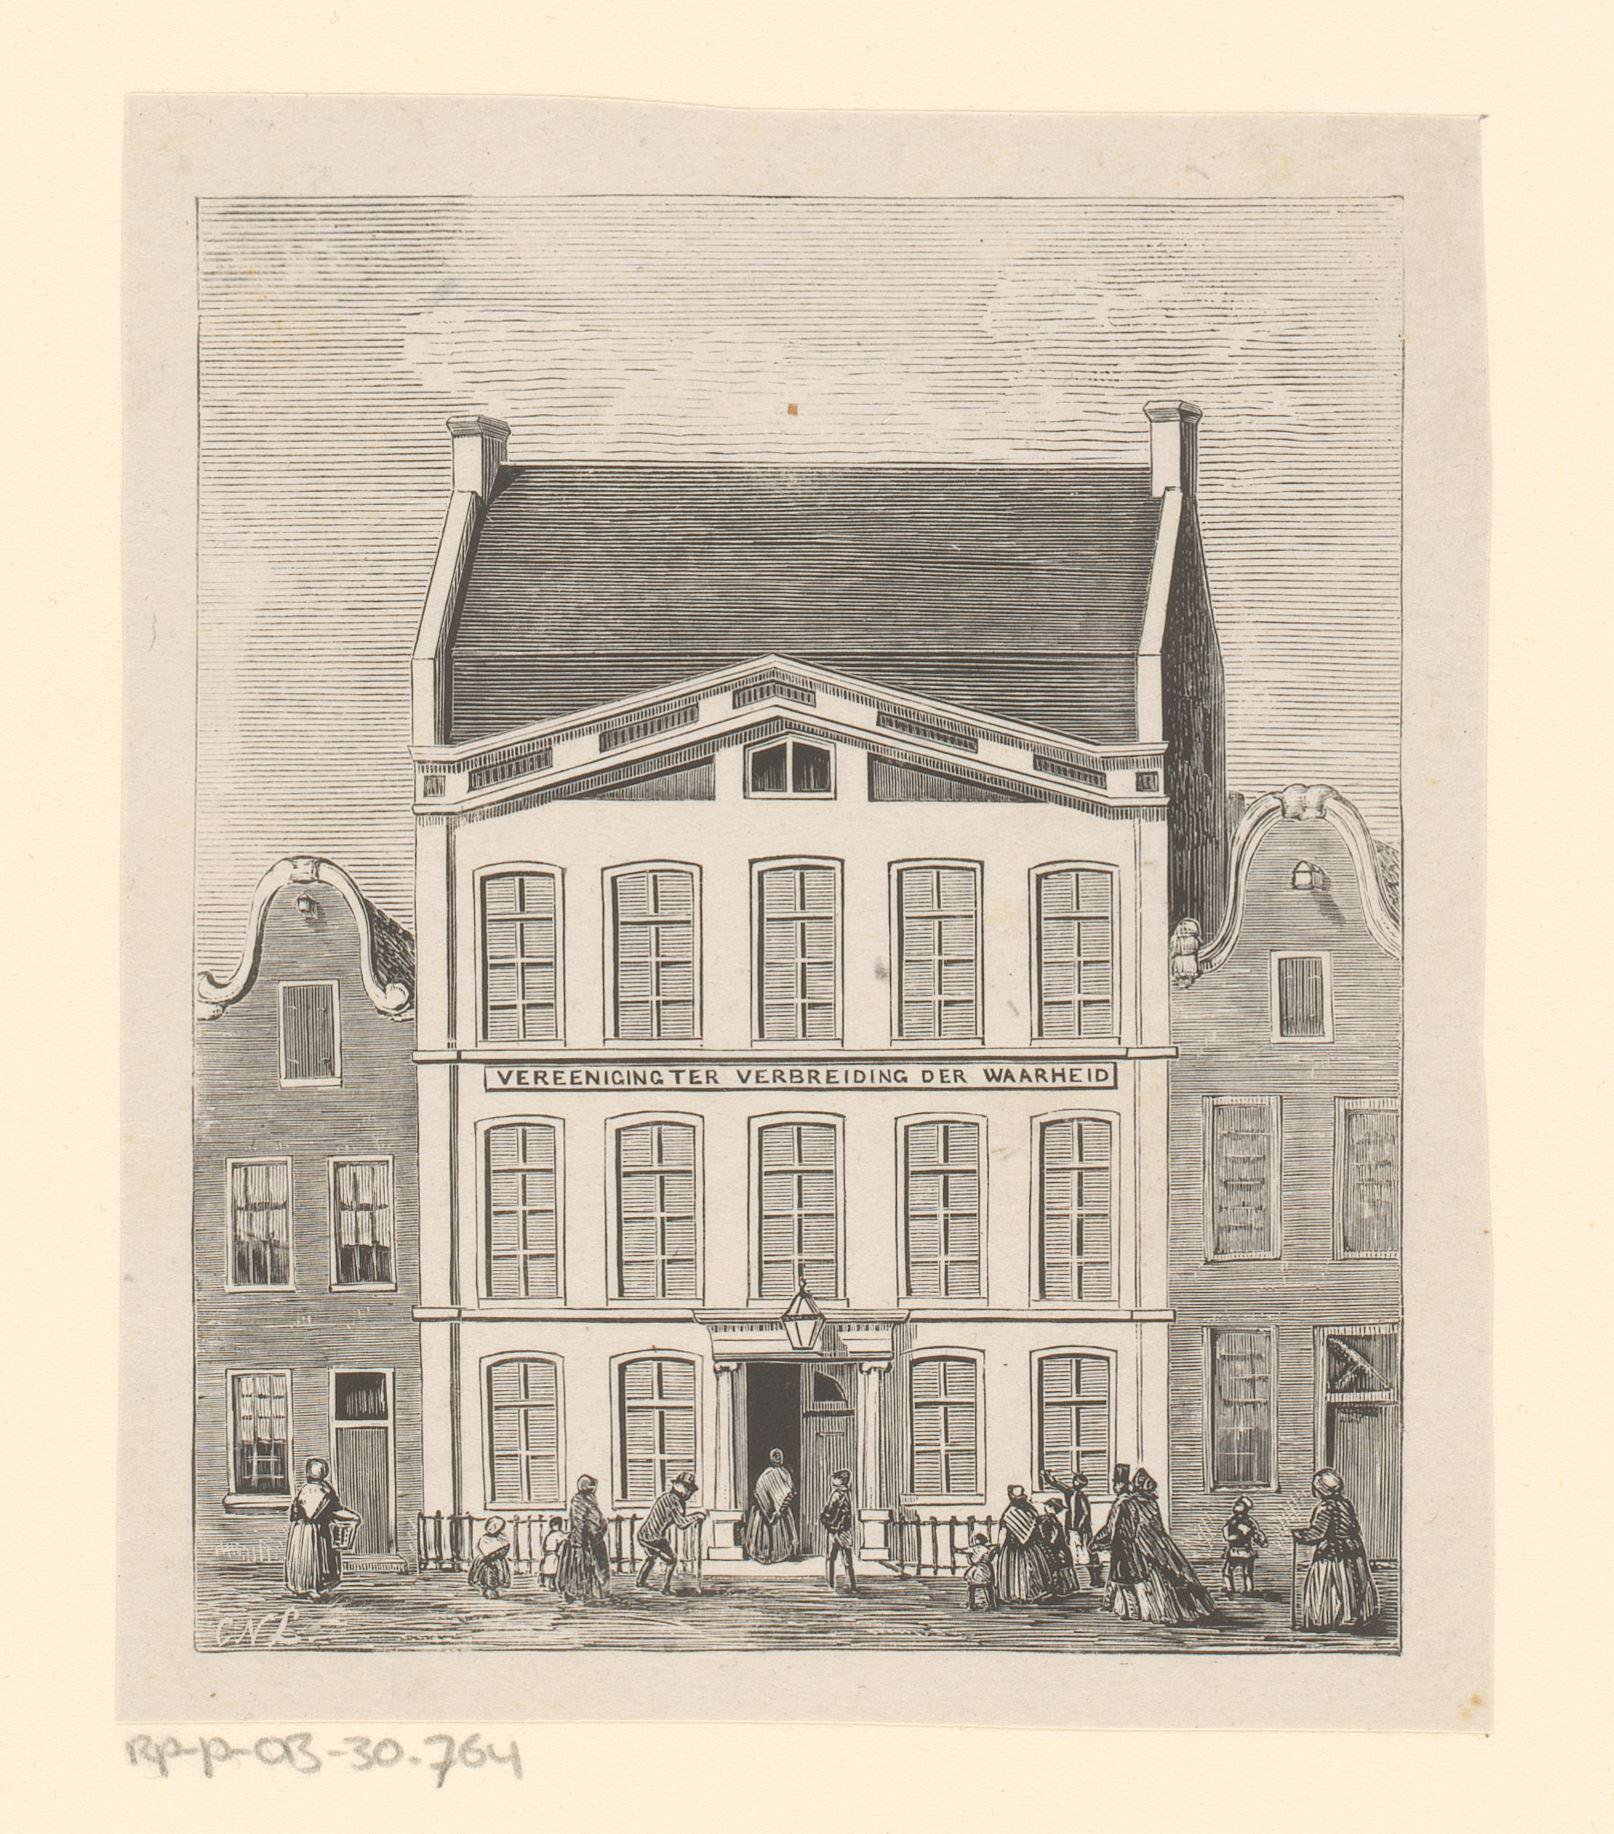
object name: print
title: Gezicht op het pand 'Vereeniging ter verbreiding der waarheid' in de Elandsstraat te Amsterdam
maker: isaac weissenbruch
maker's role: print maker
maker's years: 1826-1912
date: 1847-1912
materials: paper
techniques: engraving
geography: netherlands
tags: street (+ city(-scape) with figures, staffage), amsterdam